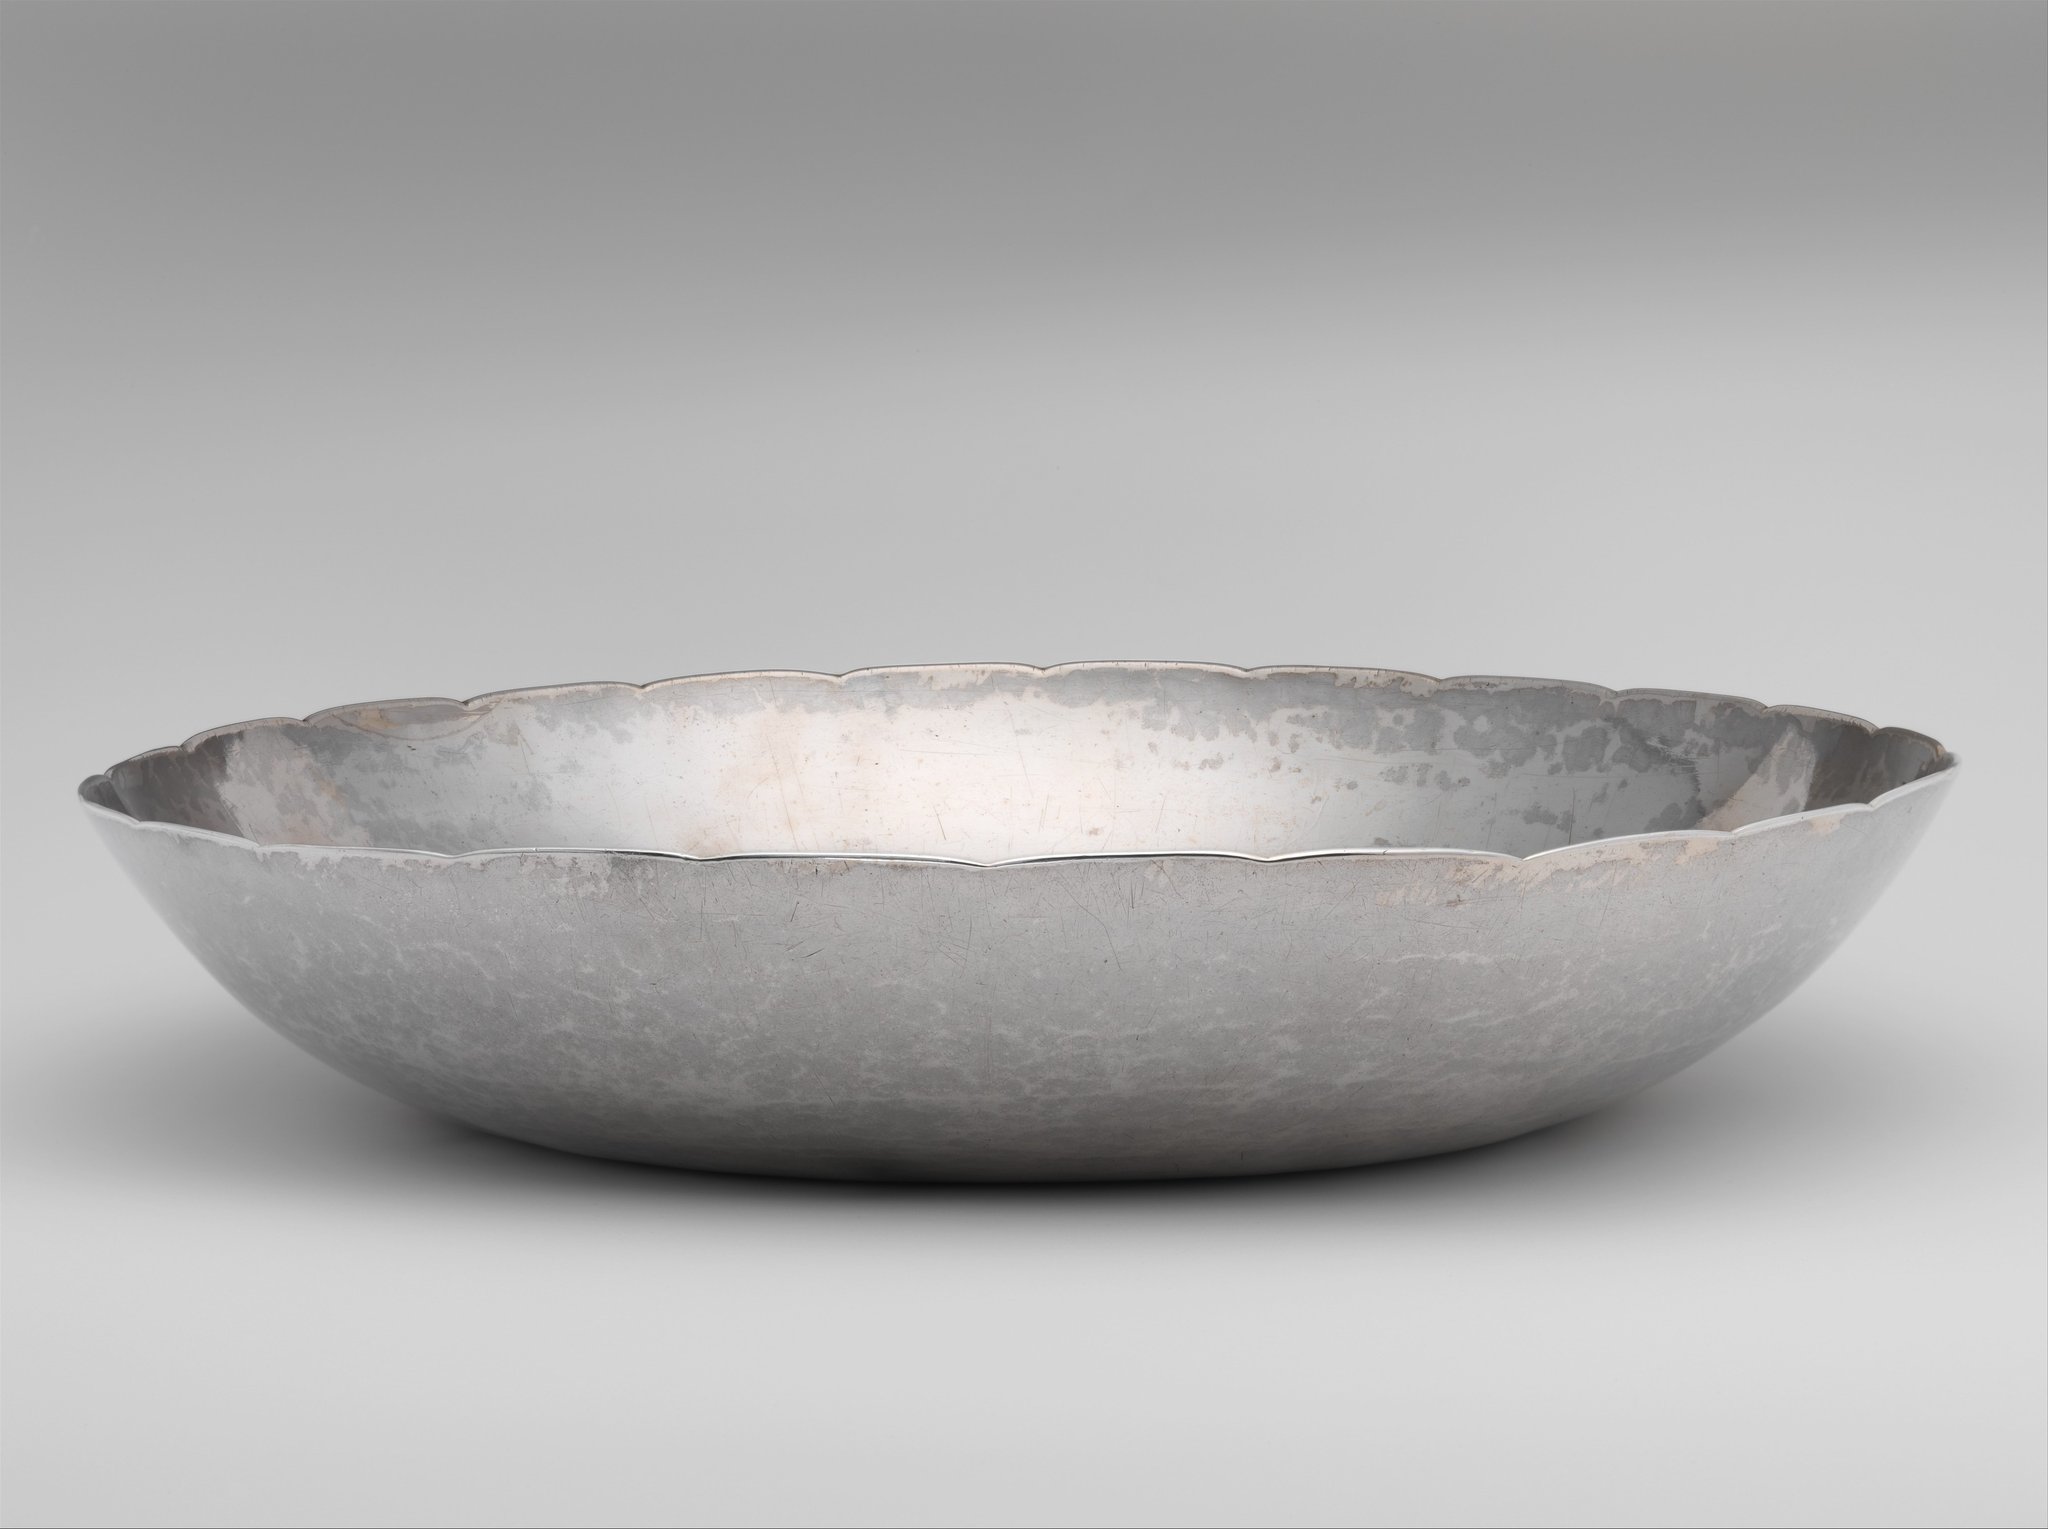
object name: dish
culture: american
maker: myer myers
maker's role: maker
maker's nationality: american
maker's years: 1723-1795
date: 1754-1770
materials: silver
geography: united states